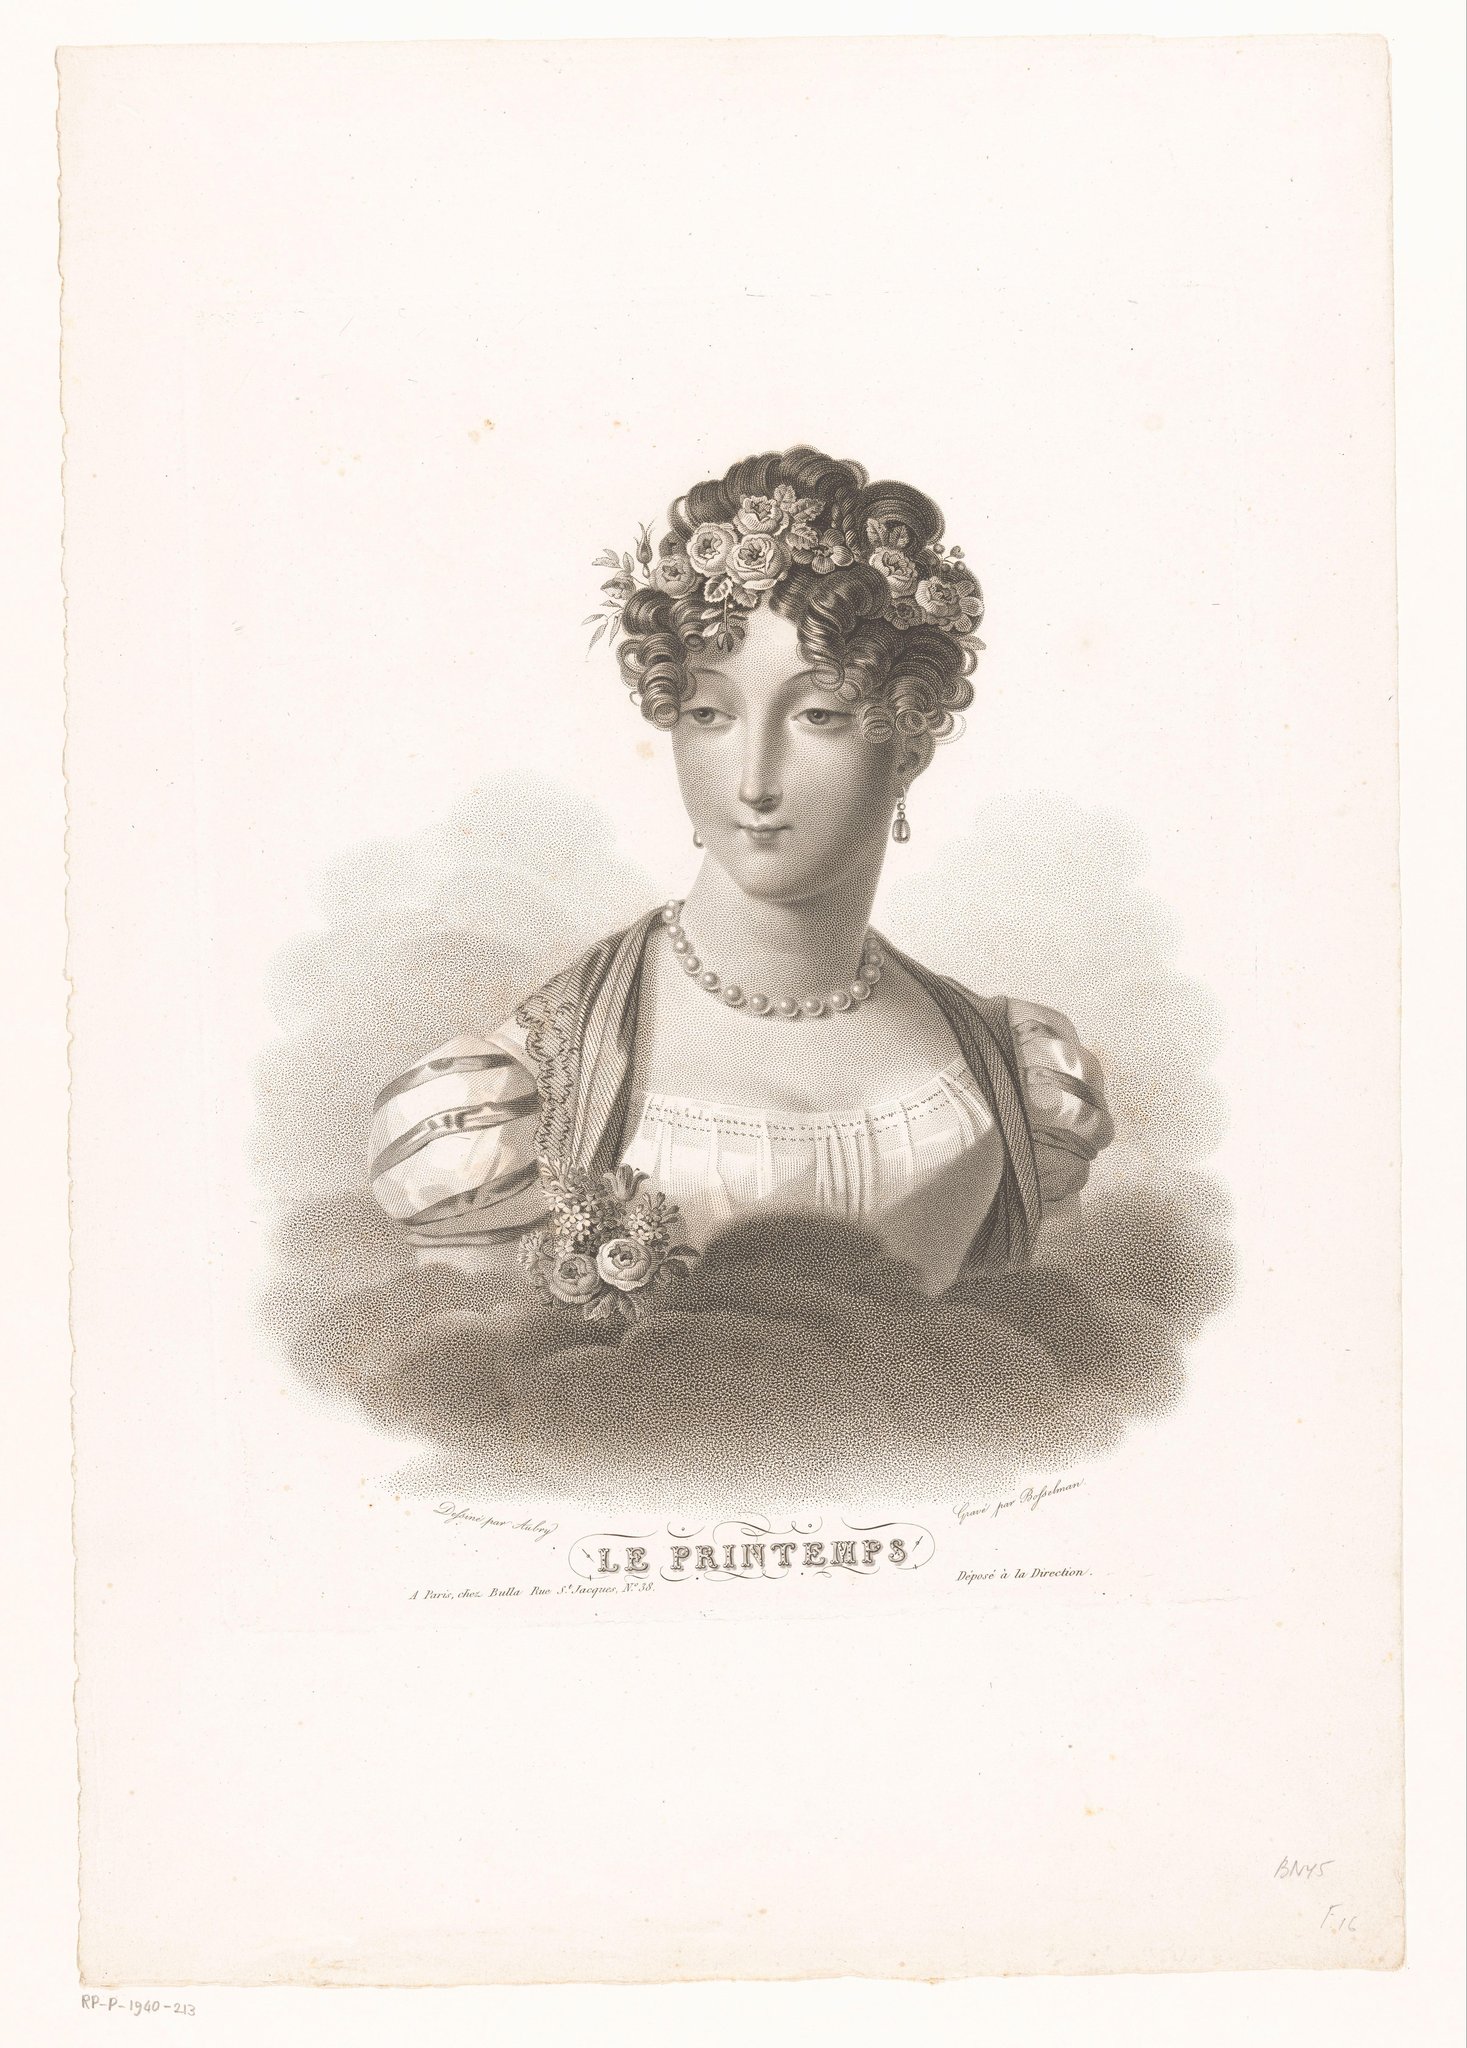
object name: print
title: Le Printemps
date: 1824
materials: paper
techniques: engraving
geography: paris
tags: year divided into four seasons, spring, 'ver'; 'primavera' (ripa)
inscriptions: collector's mark: Lugt 2228, : ‘Déposé à la Direction.’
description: Maakt deel uit van een serie van vier prenten voorstellende de vier seizoenen in de vorm van vier vrouwen in seizoensgebonden kostuums.